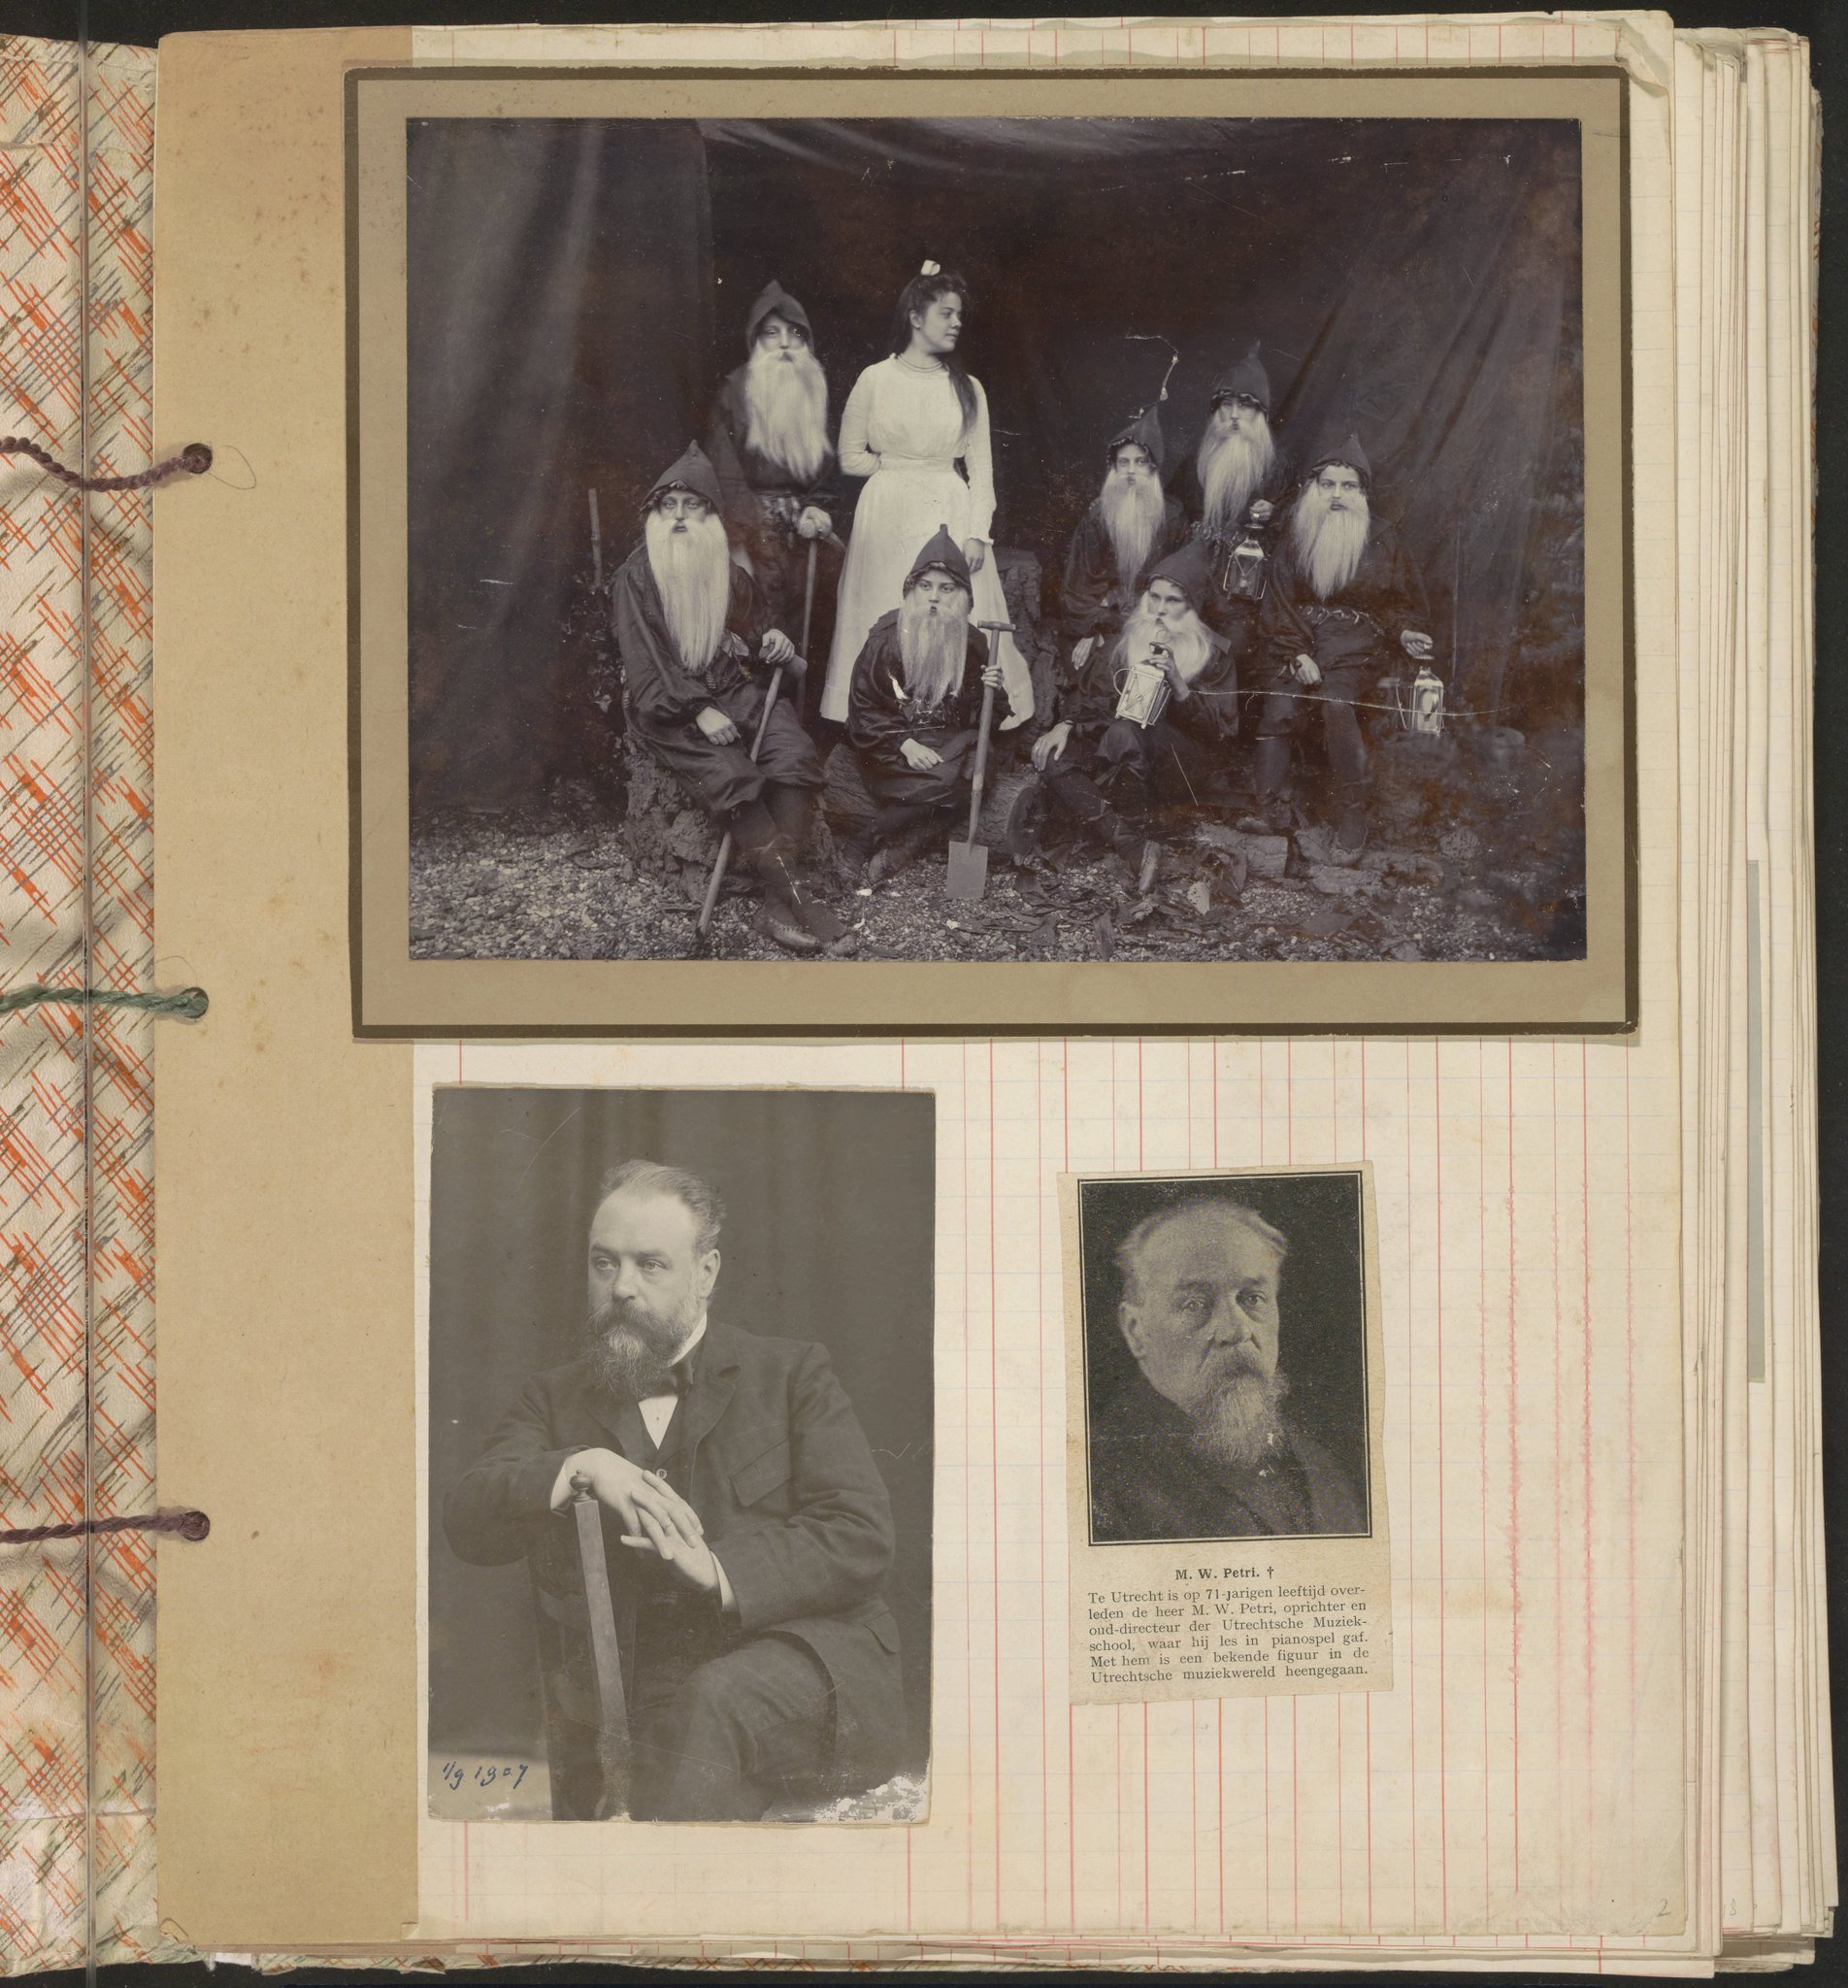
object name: album leaf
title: Groepsfoto, portret en overlijdensbericht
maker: Anonymous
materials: paper, photographic support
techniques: gelatin silver print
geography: netherlands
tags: utrecht, adolescent, young woman, maiden, studio requisites ~ photographer, adult man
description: Albumblad met een foto van kinderen verkleed als Sneeuwwitje en de zeven dwergen, een portret van (vermoedelijk) Martinus W. Petri en zijn overlijdensbericht. Onderdeel van Fotoalbum van de familie Petri.